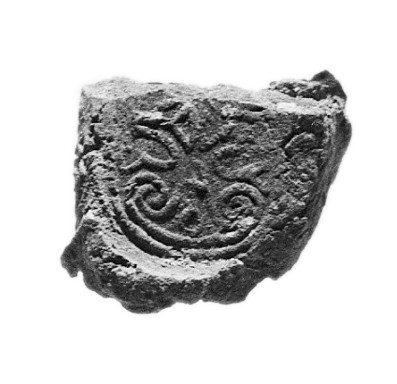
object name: sealing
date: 1981-1640 BCE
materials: mud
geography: egypt